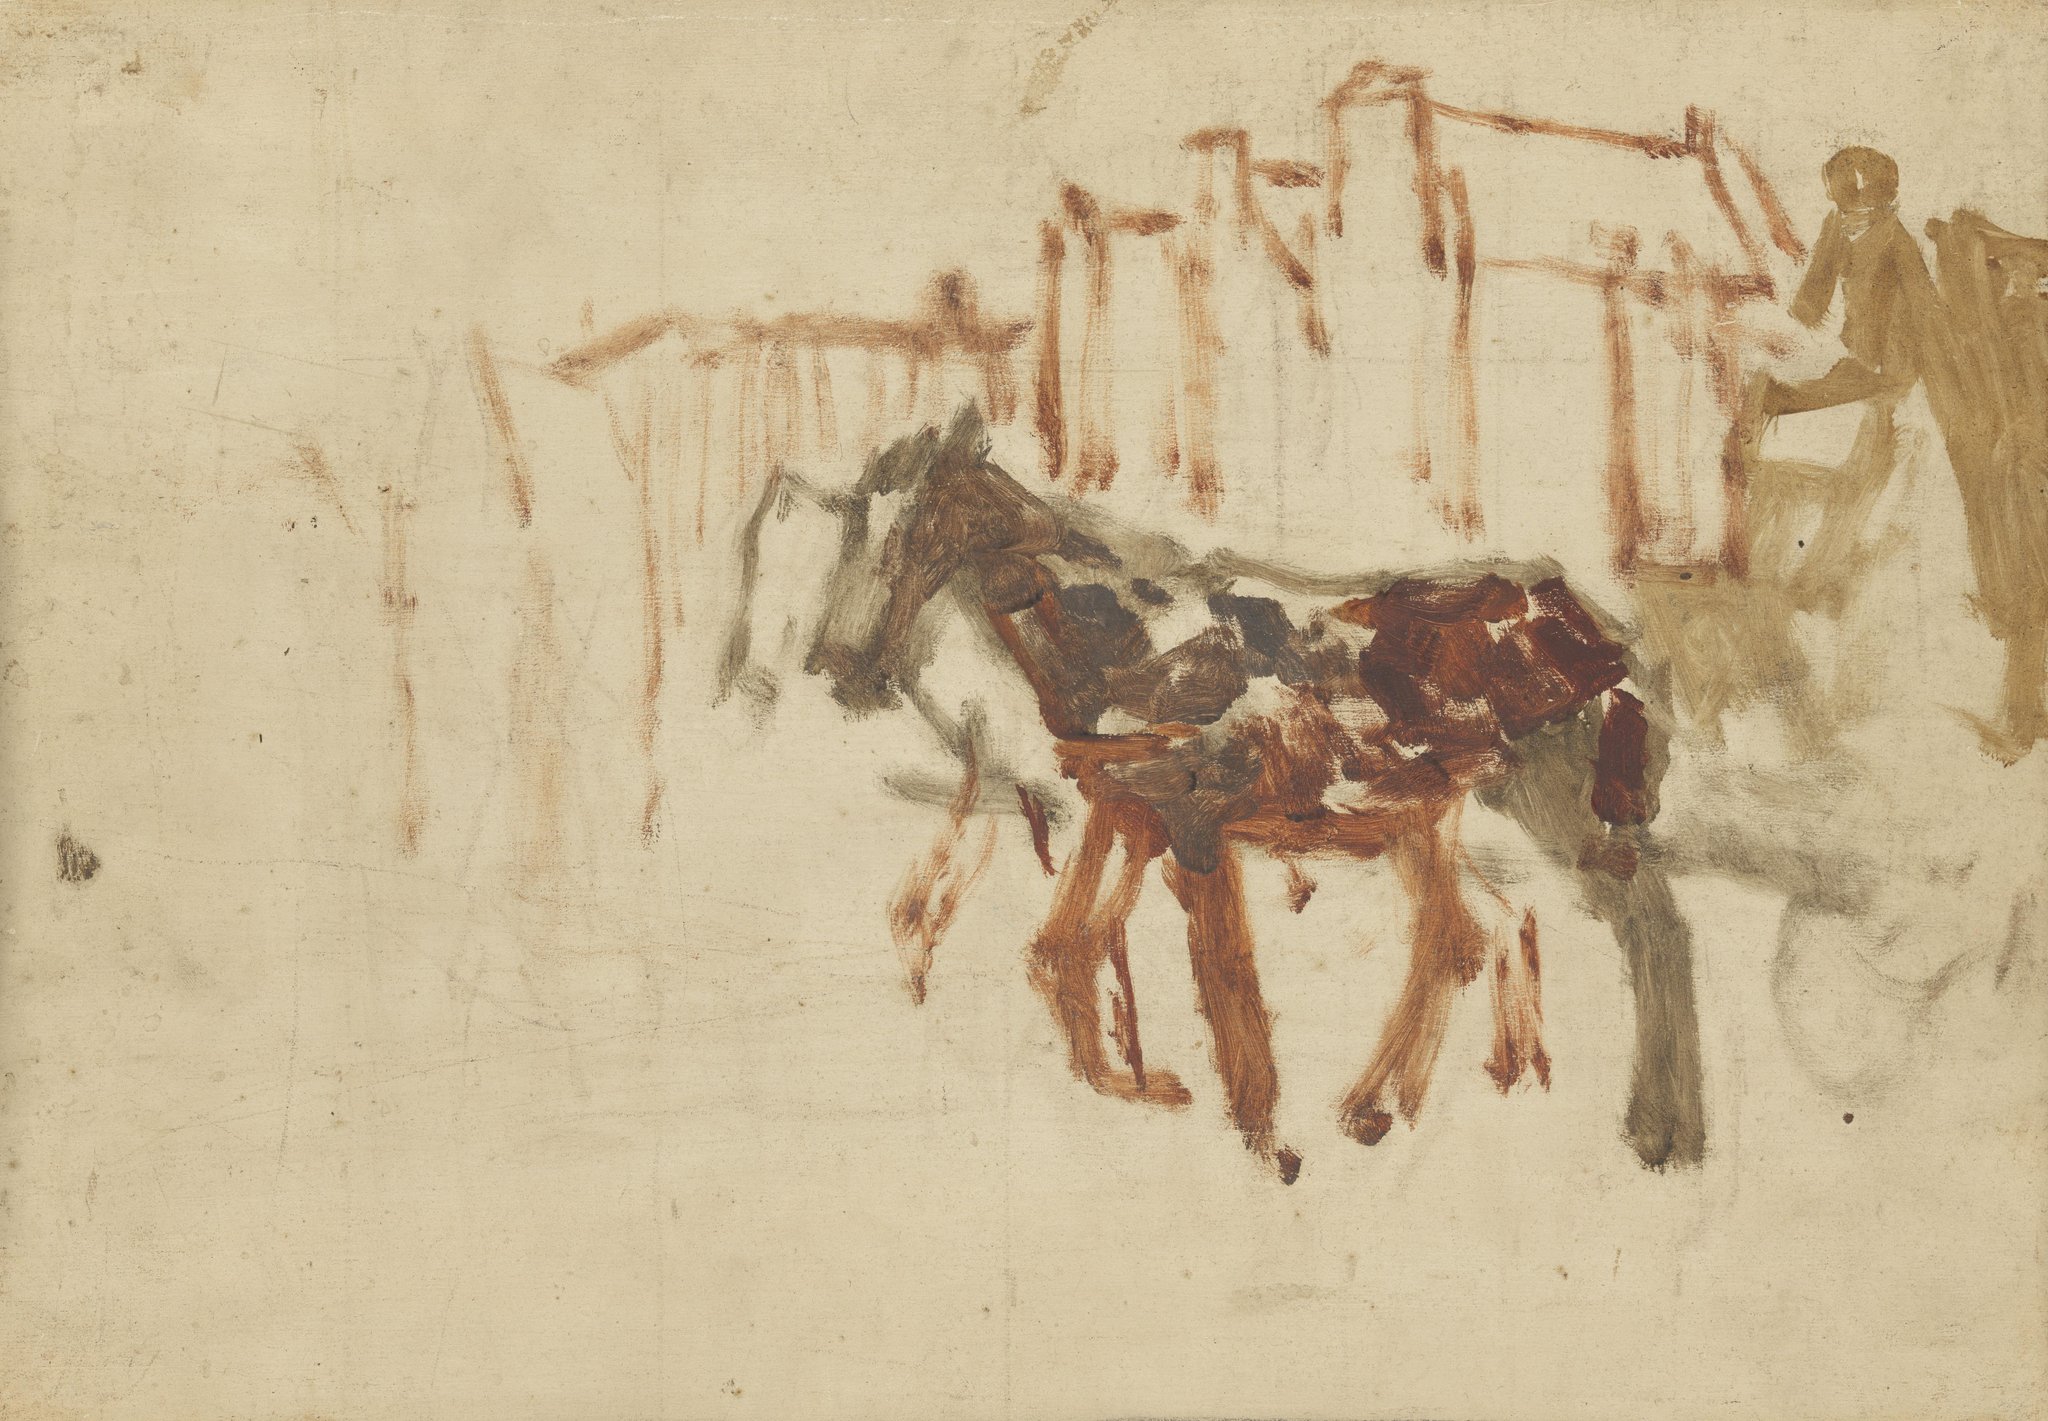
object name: preparatory study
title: The Rokin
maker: george hendrik breitner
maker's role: draughtsman, painter, print maker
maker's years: 1857-1923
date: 1880-1923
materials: oil, panel, pencil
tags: horse, four-wheeled vehicle drawn by two animals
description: Horses were Breitner’s first subject and remained a life-long passion. This sketch shows how he made a preliminary lay-out of a cityscape. He did this on the spot, using a small panel that fit into the lid of his painter’s box. He depicted the two horses and the horse tram, as well as the contours of the houses, with swift strokes in brown tints over the summary underdrawing.